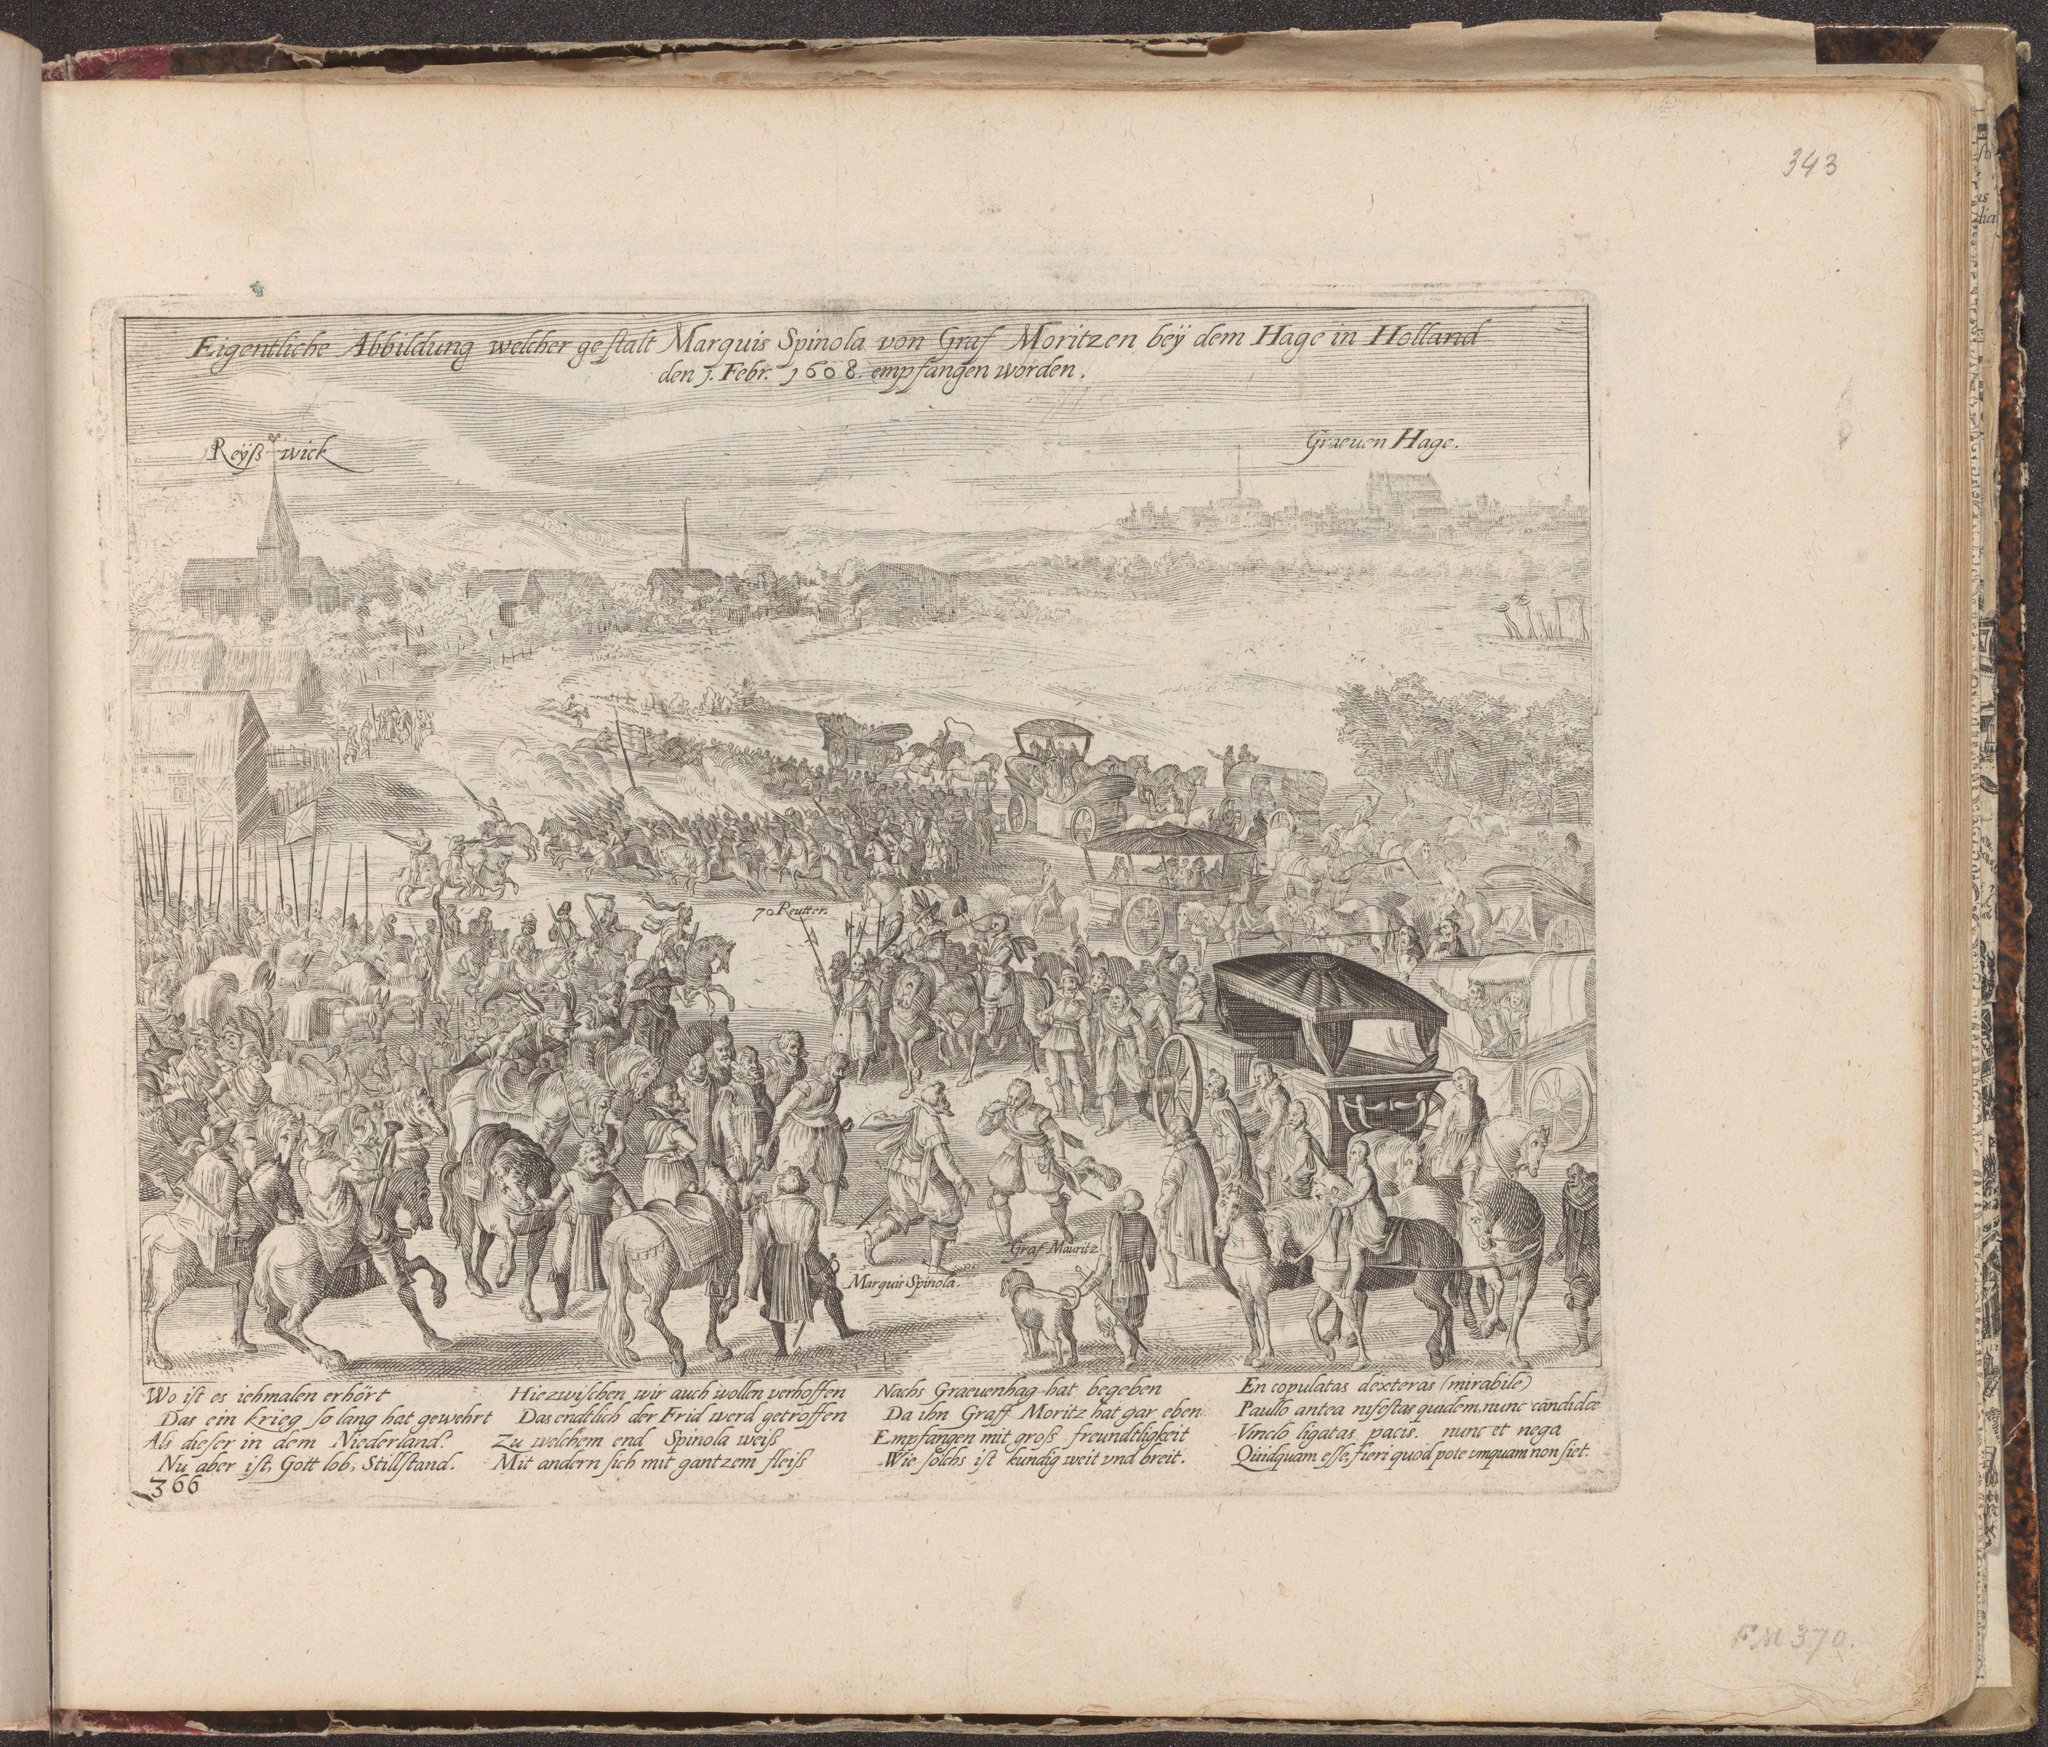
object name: album leaf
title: Maurits ontvangt Spinola in Rijswijk, 1608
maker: frans hogenberg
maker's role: print maker, publisher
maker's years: 1538-1590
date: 1608-1610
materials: paper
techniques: etching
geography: cologne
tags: maurice (prince of orange), peace negotiations, meeting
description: Prins Maurits ontvangt Spinola en zijn gevolg te Rijswijk voor vredesbesprekingen, 1 februari 1608. In de verte Den Haag. Met onderschrift van 12 regels in het Duits en 4 regels in het Latijn. Linksonder genummerd: 366. De prent maakt deel uit van een album.